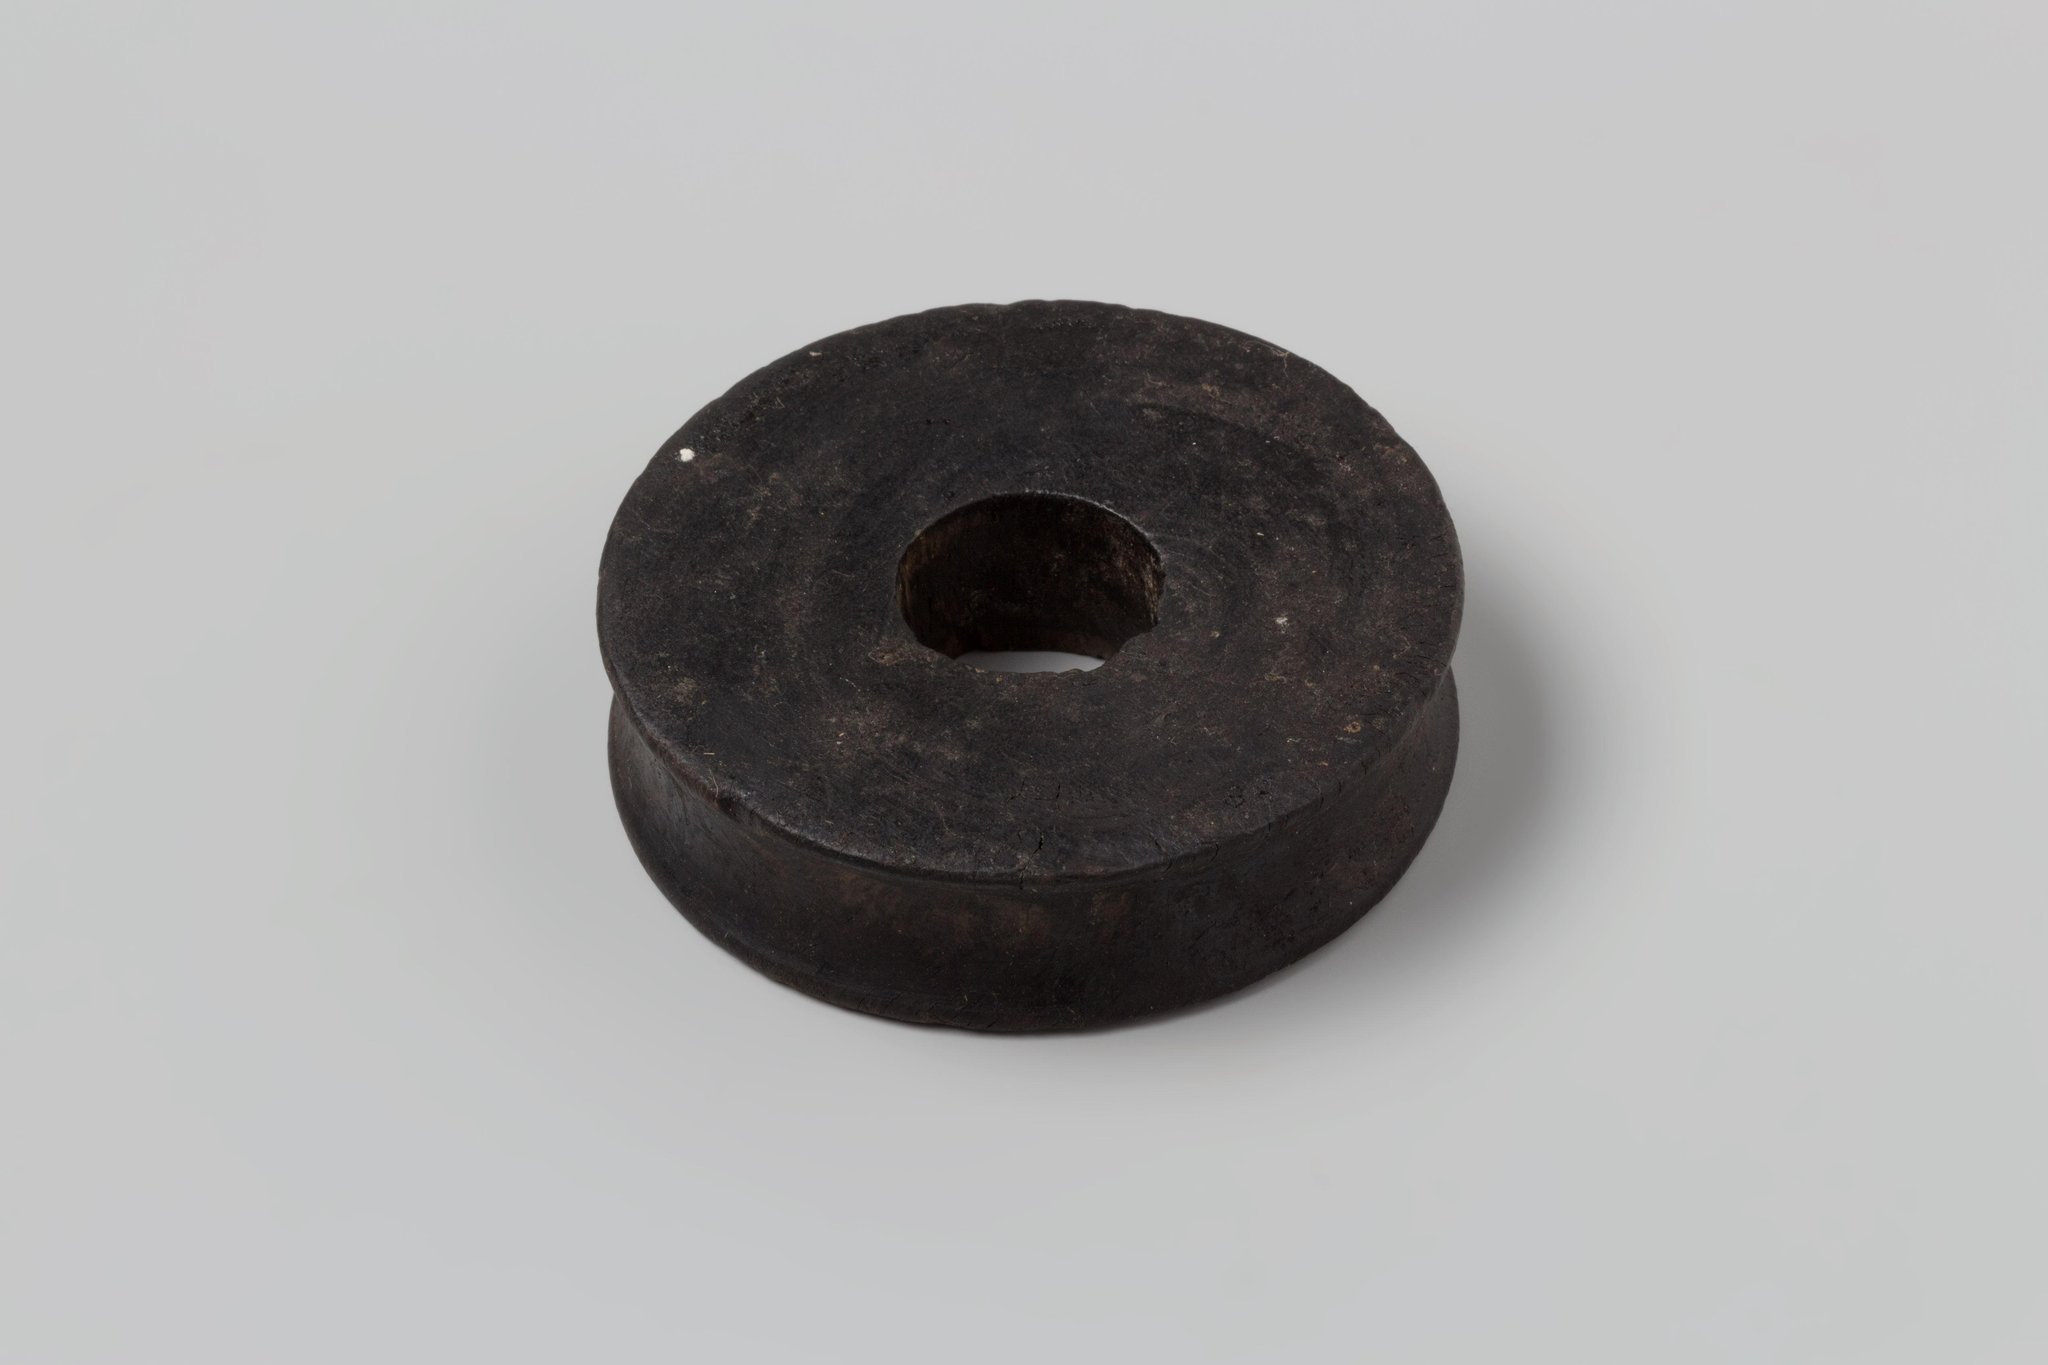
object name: disk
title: Schijf uit V.O.C.-schip de 'Witte Leeuw'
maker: Anonymous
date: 1613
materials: wood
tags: verenigde oostindische compagnie, sint-helena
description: Schijf uit V.O.C.-schip de 'Witte Leeuw'.